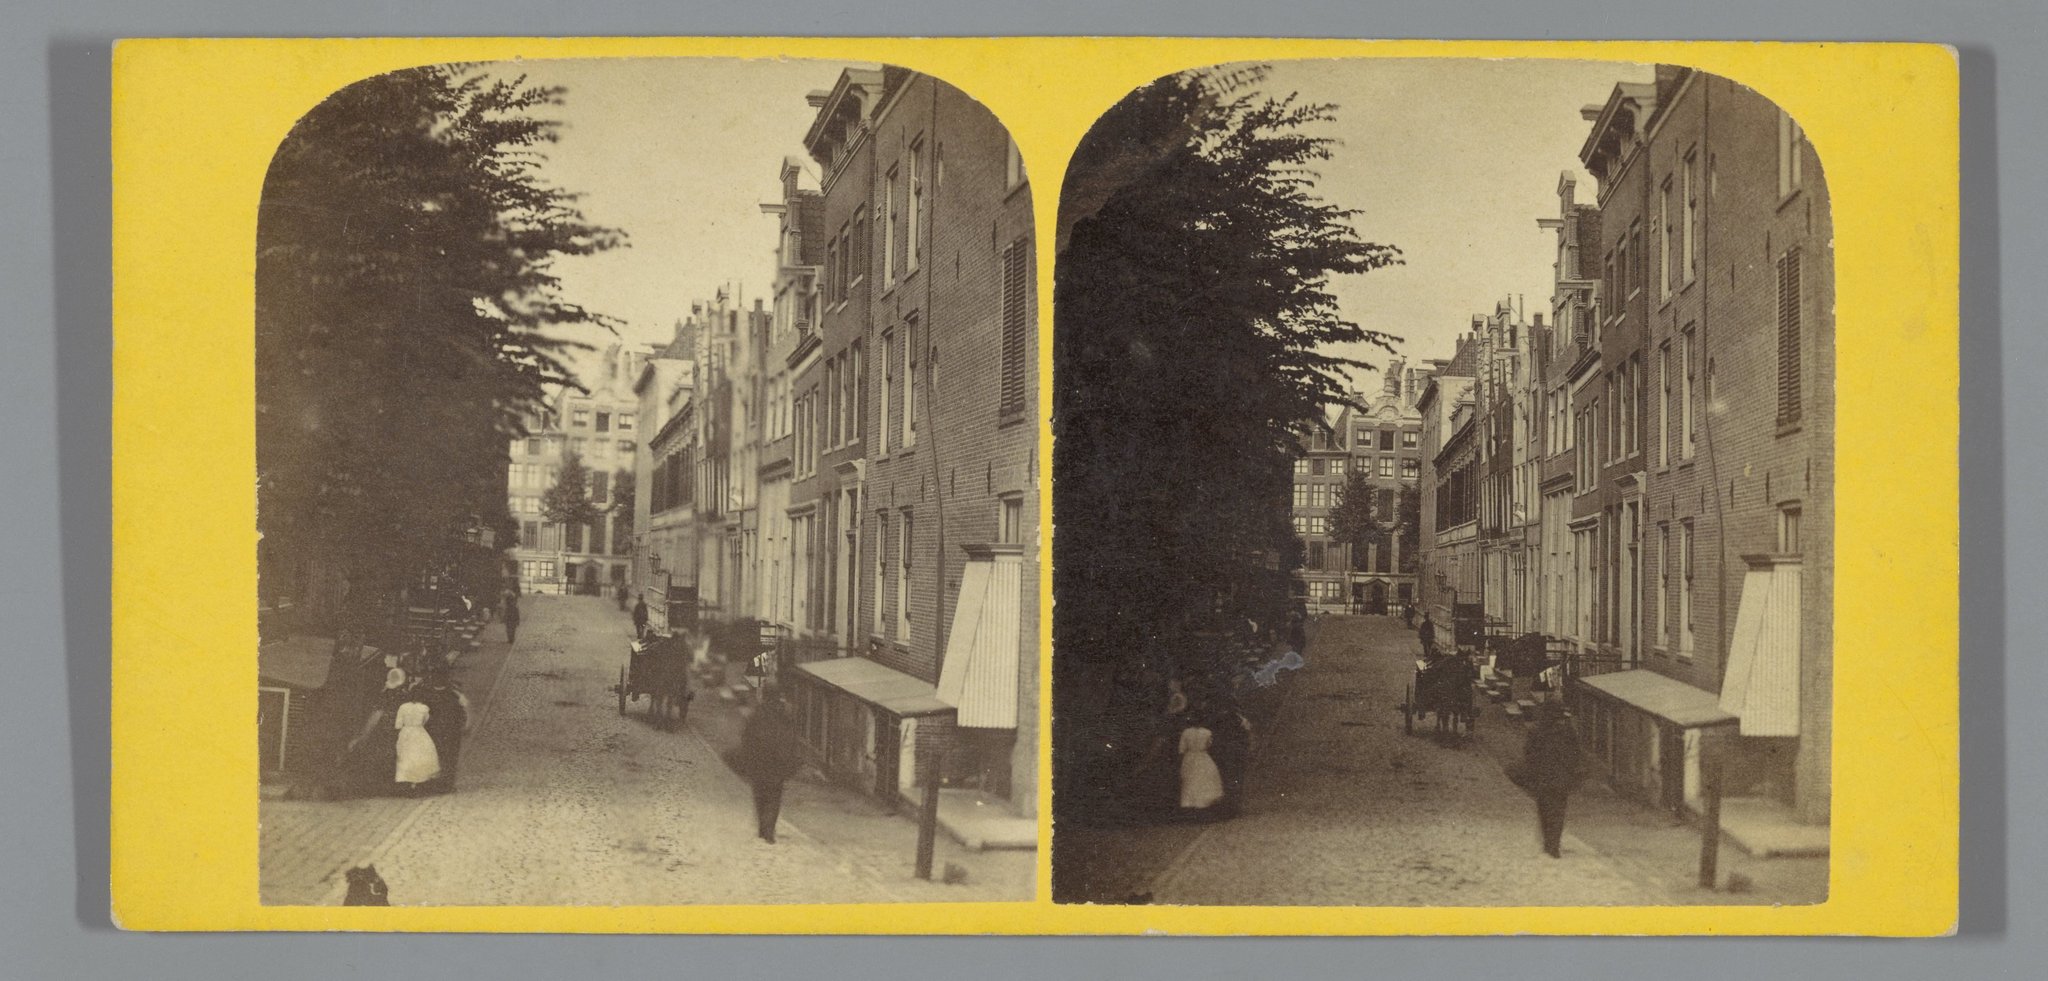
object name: stereograph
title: Gezicht op de Spiegelstraat in Amsterdam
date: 1860-1885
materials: cardboard, photographic support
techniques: albumen print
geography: amsterdam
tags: street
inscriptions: inscription: ‘No. 188./ DE SPIEGELSTRAAT/ TE/ Amsterdam./ A. JAGER, WATER 110, TE AMSTERDAM.’, number: ‘25’